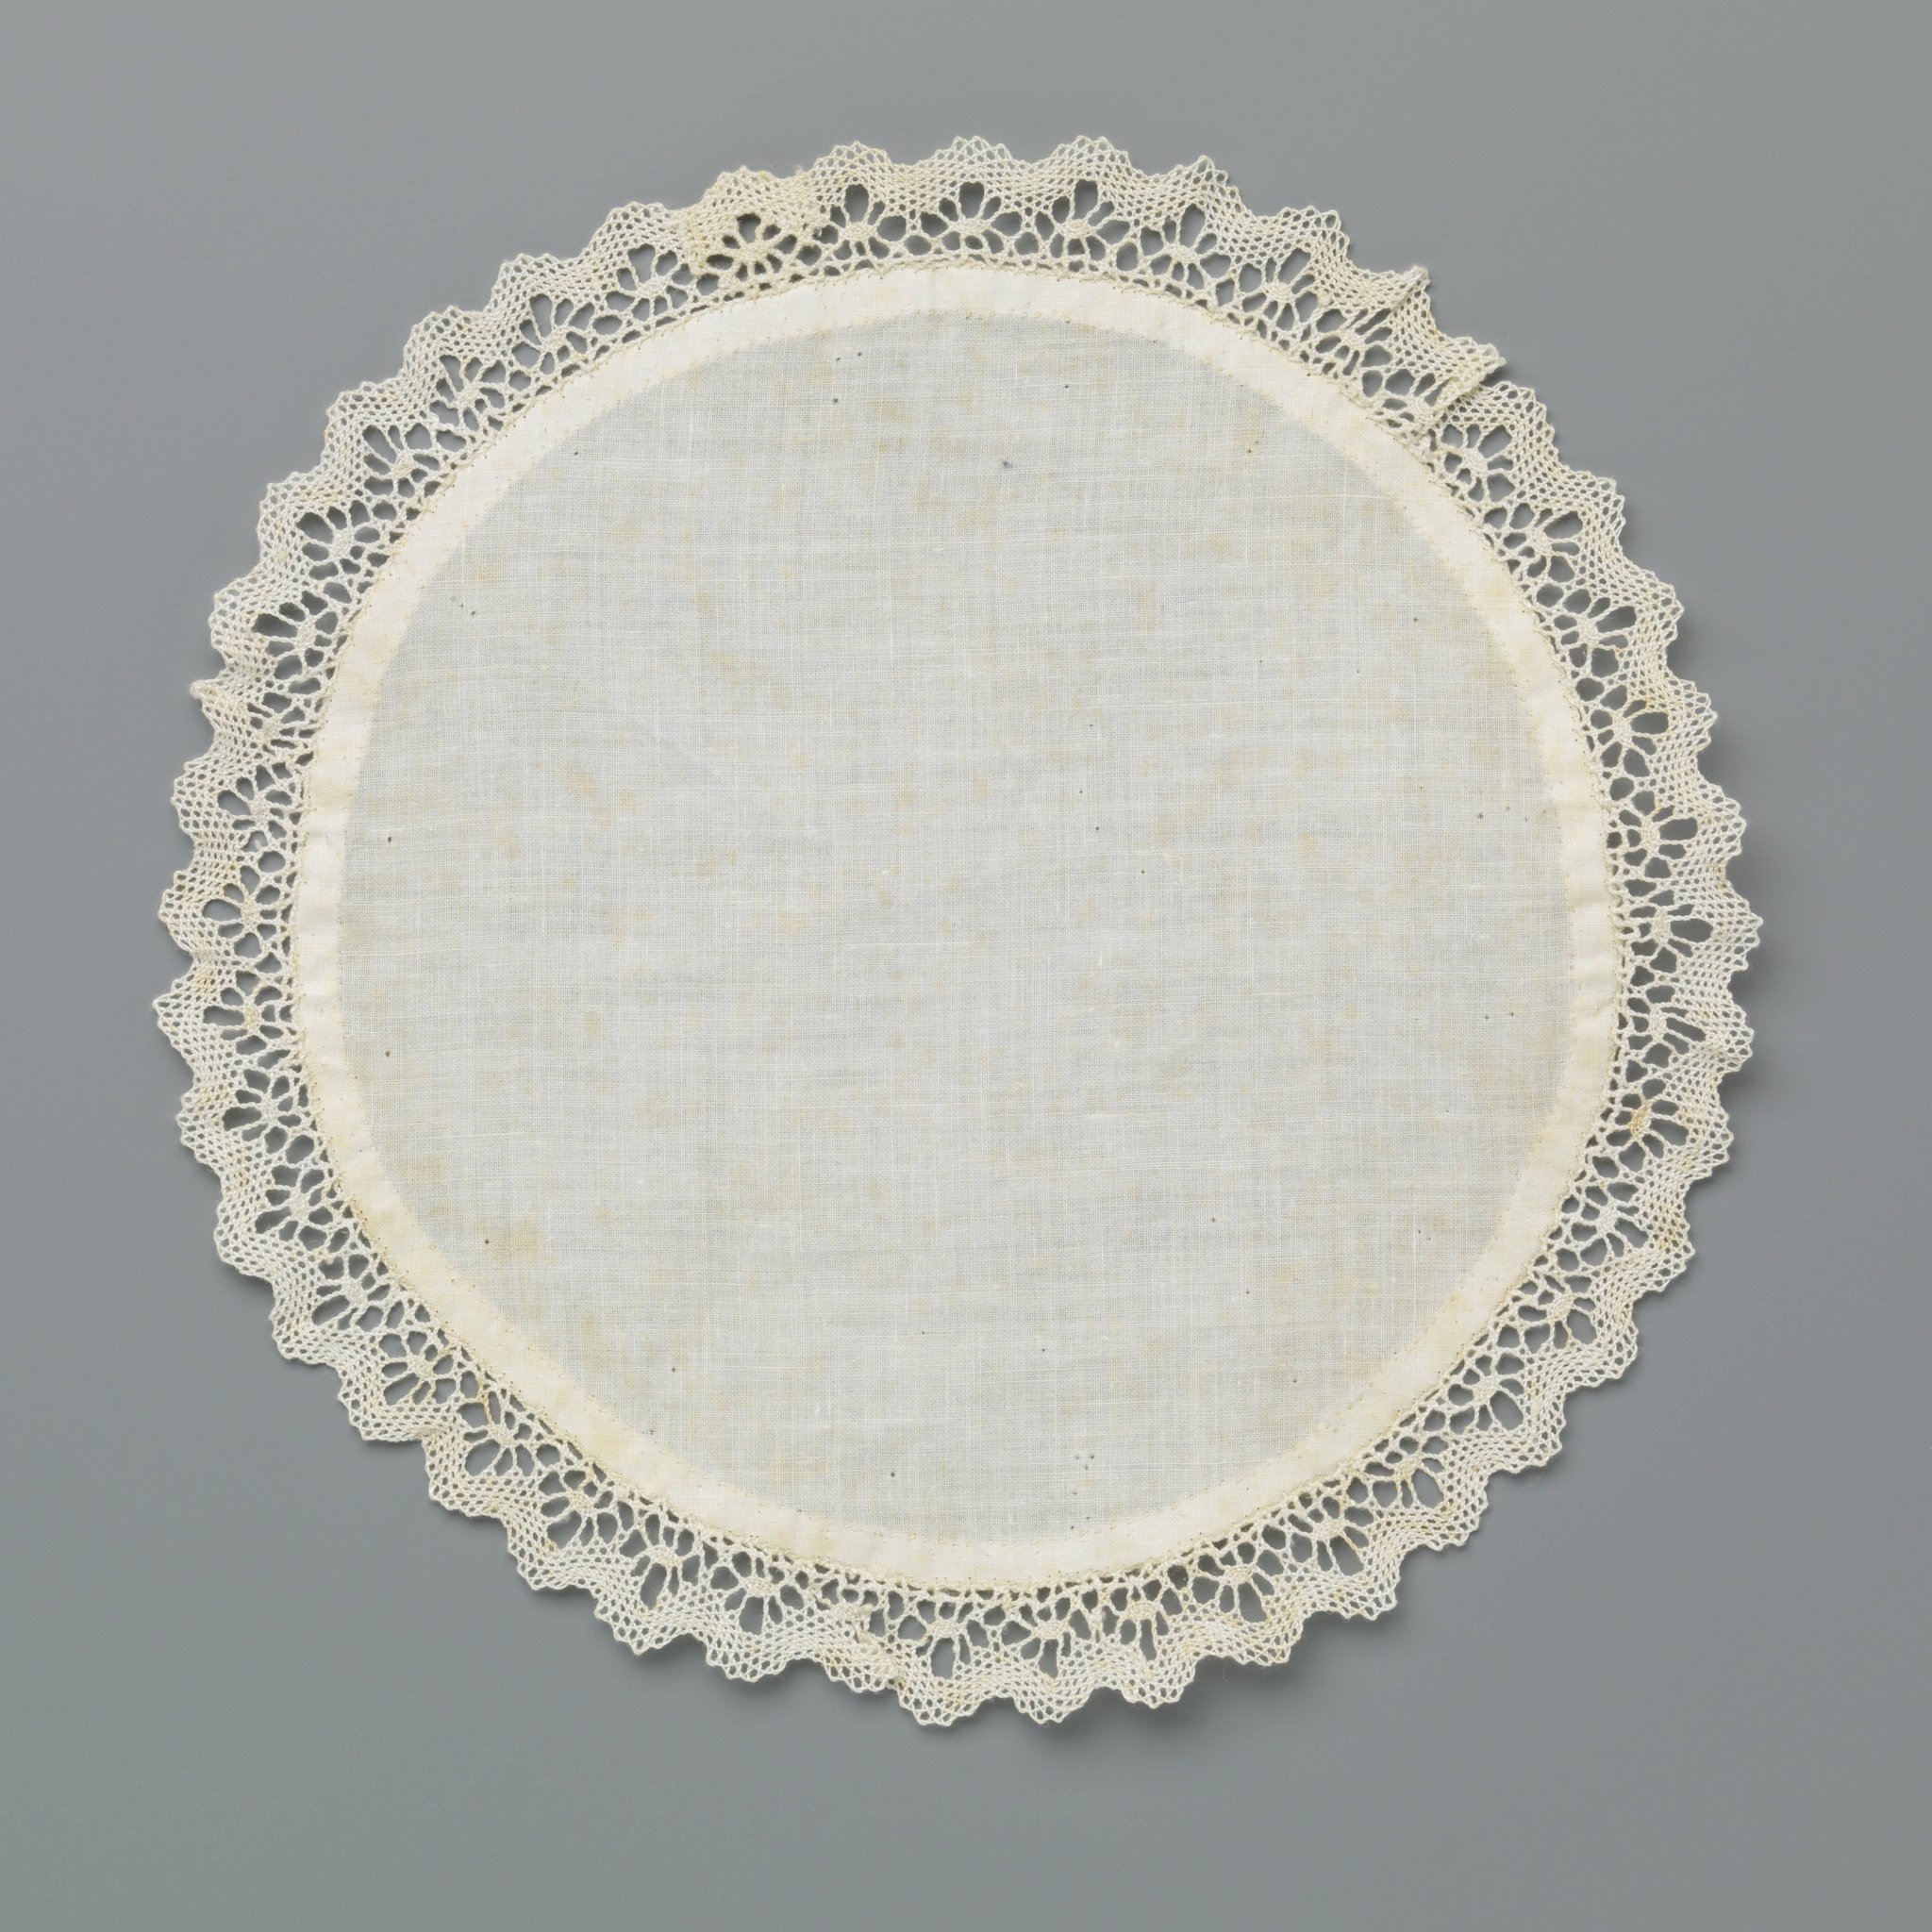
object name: doily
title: Doily van batist met golvend randje kloskant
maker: Anonymous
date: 1900-1949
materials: textile, cotton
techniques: lace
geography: netherlands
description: Doily, een rond kleedje, van batist met een randje kloskant. Het zich herhalende patroon bestaat uit één rij spinnen, met vlechtjes verbonden aan een eenvoudige binnenrand en de schulpenrand aan de buitenzijde, die is gevormd met een smalle golvende baan in netslag.